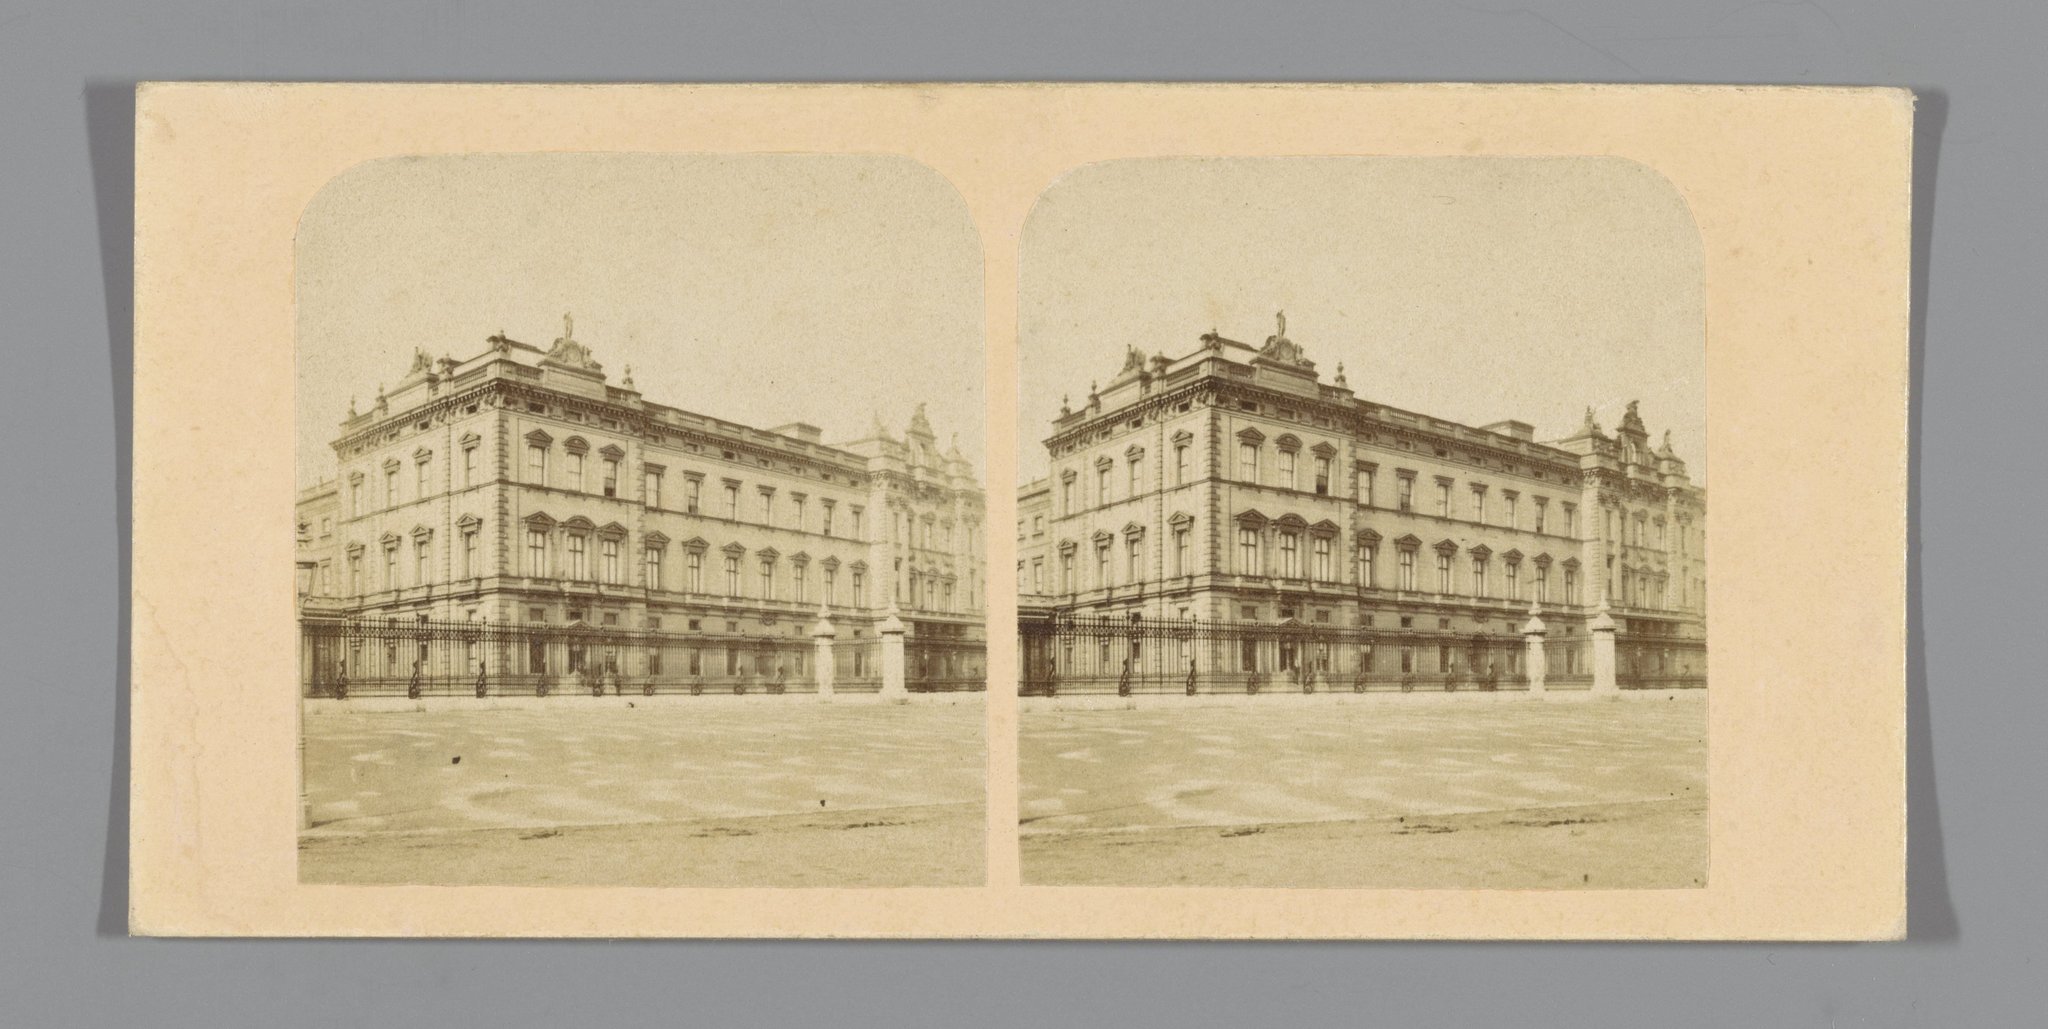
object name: stereograph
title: Views of London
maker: Anonymous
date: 1850-1880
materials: cardboard, photographic support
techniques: albumen print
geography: london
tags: palace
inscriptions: number: ‘36.’